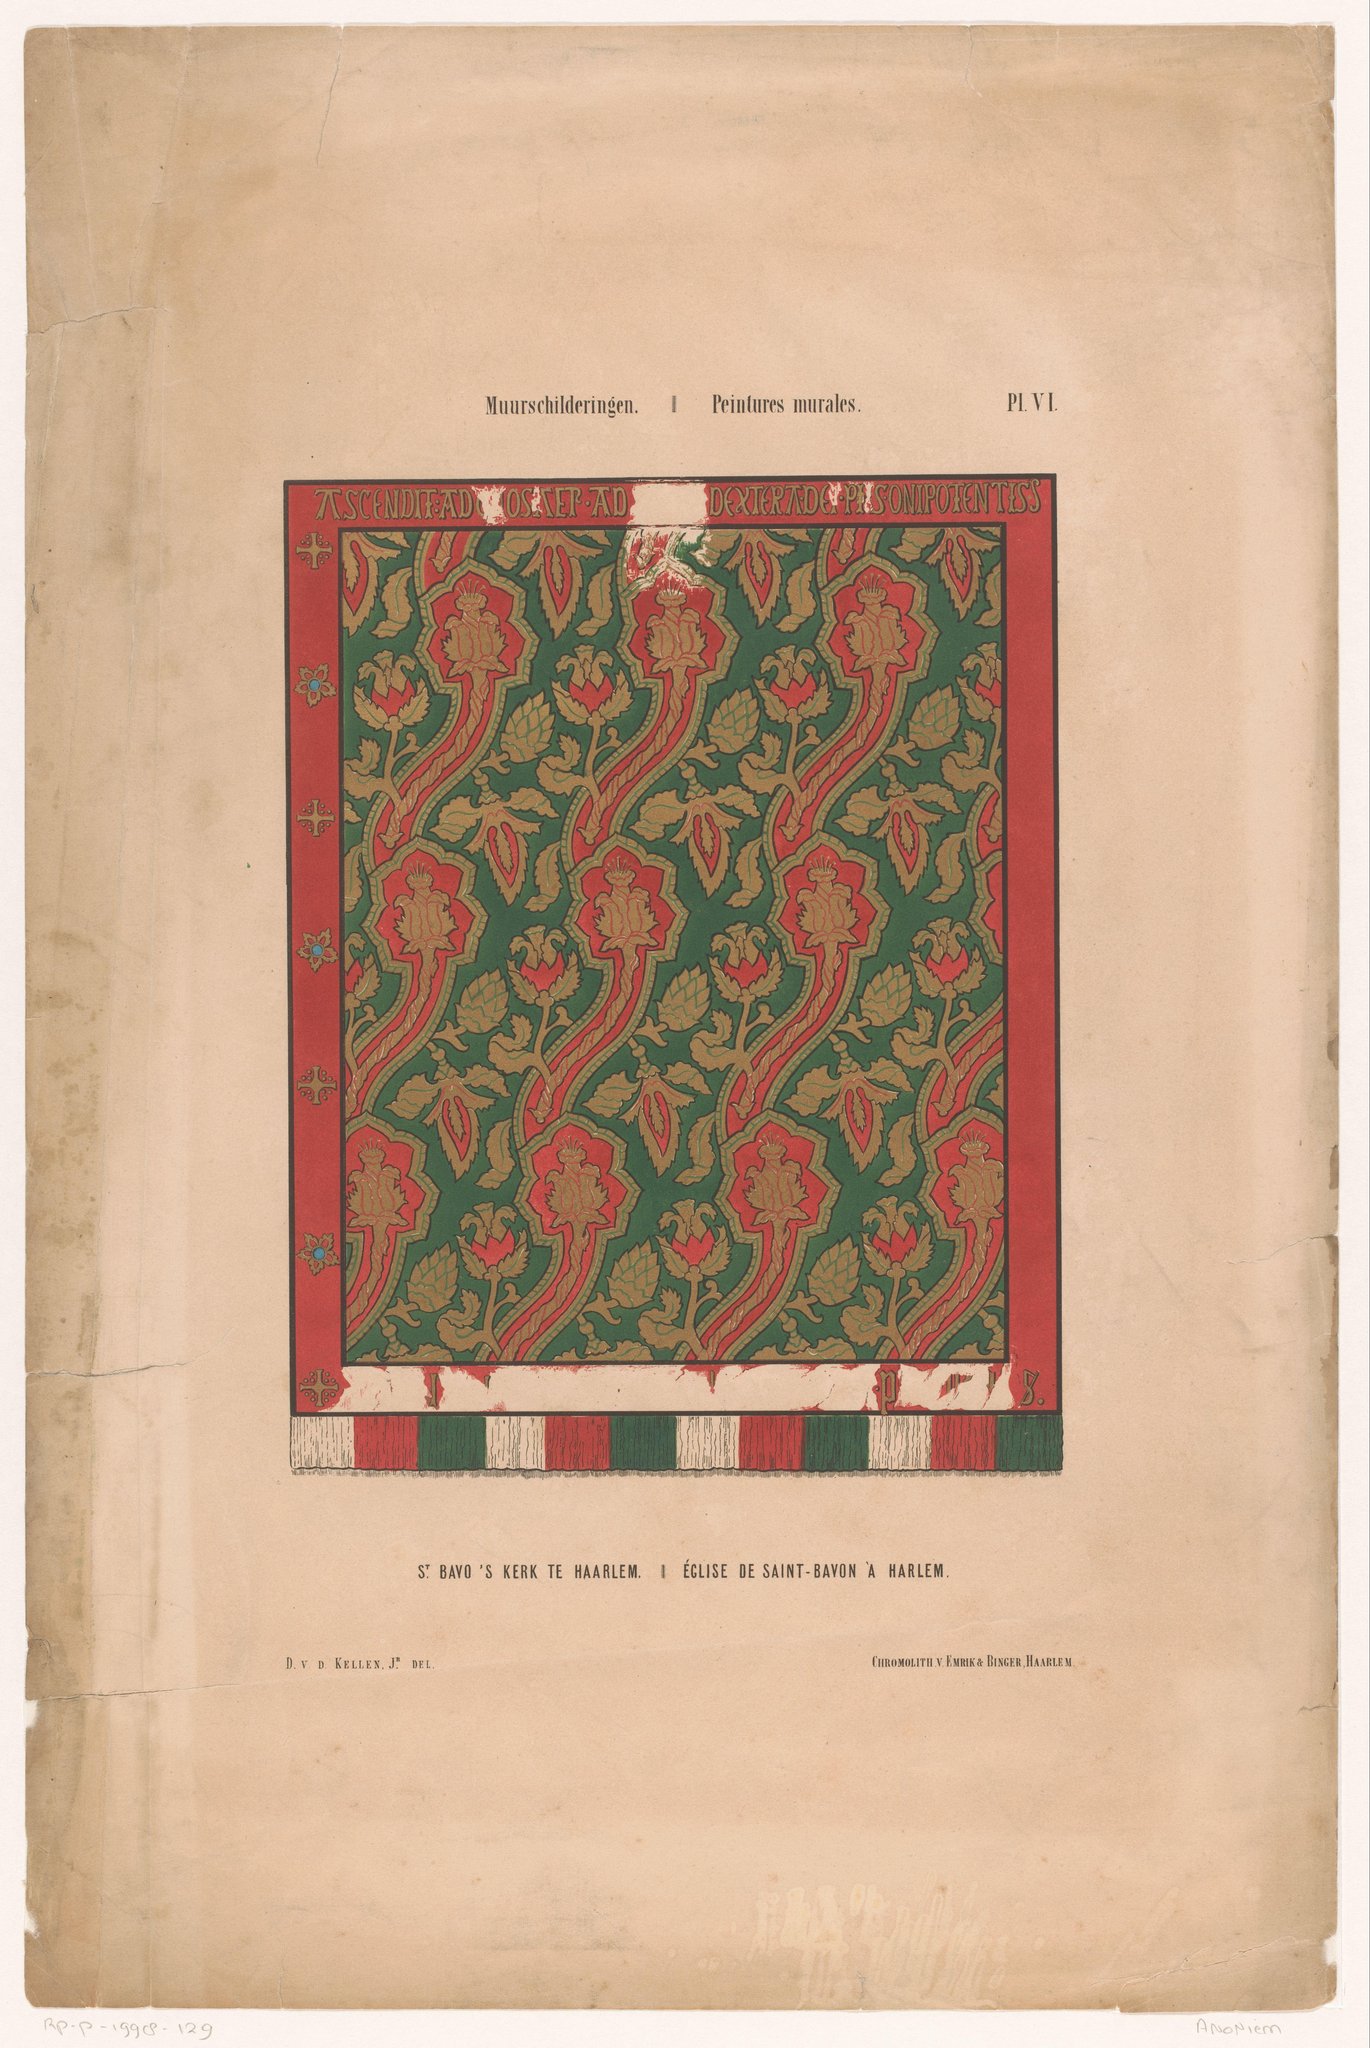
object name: print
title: Muurschilderingen / Peintures murales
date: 1857-1910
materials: paper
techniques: chromolithography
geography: haarlem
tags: wall-covering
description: Detail met ranken van een muurschildering in de Sint-Bavokerk te Haarlem. Aan de bovenzijde een Latijnse tekst.